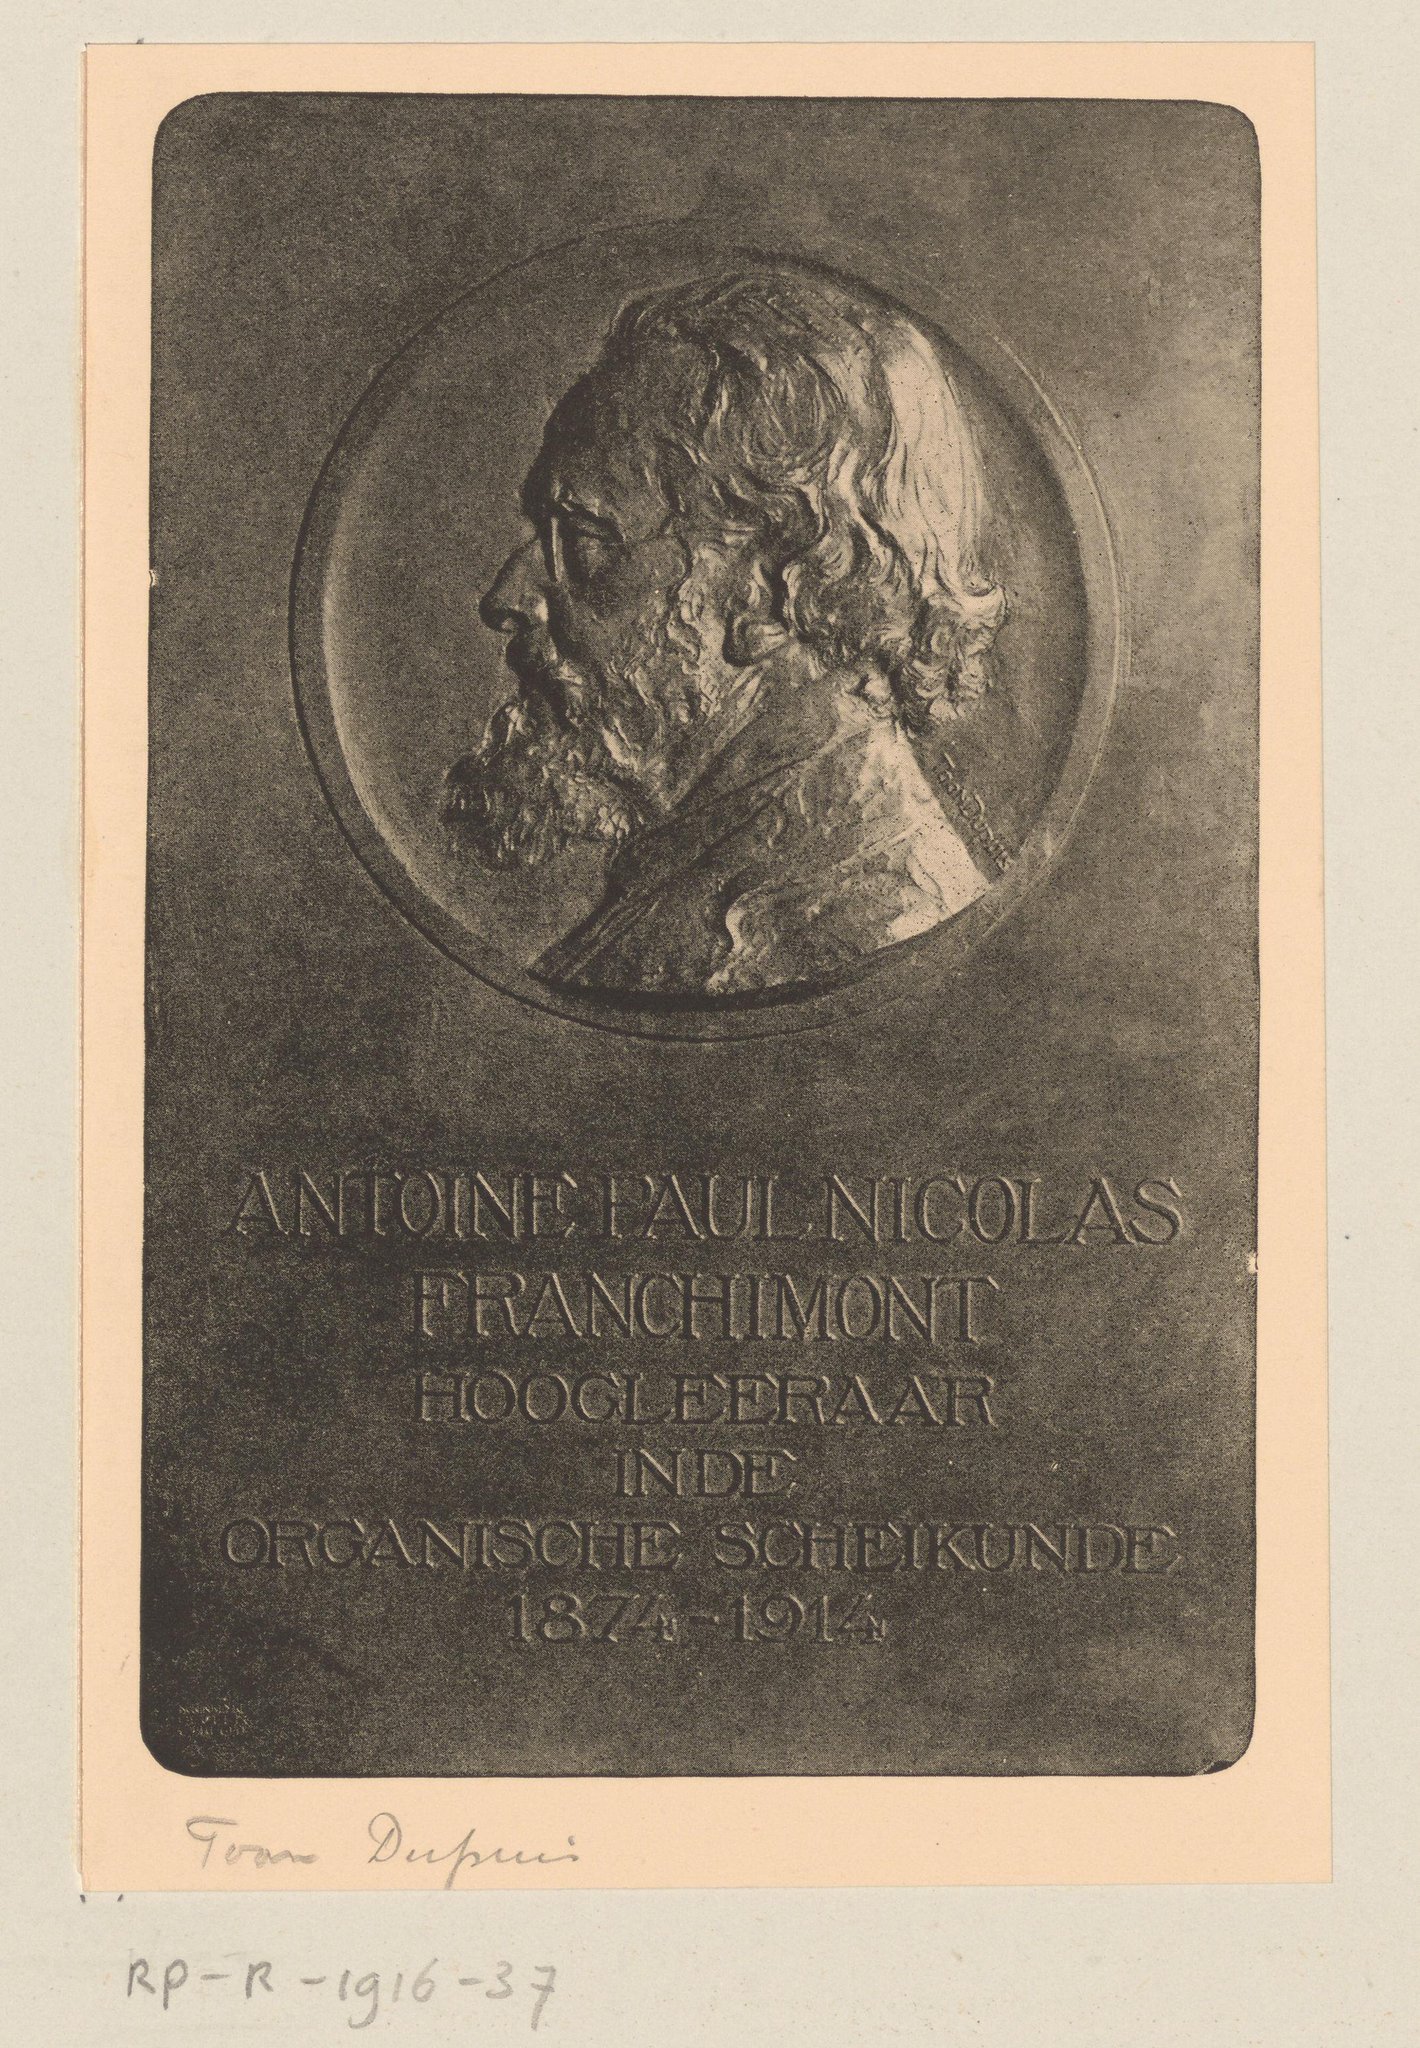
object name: reproduction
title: Portret in reliëf van Antoine Paul Nicolas Franchimont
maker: Anonymous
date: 1914-1916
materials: paper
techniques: autotype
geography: netherlands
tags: leiden, chemistry (+ portrait of scholar, scientist), historical persons, professor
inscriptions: collector's mark: Lugt 2228